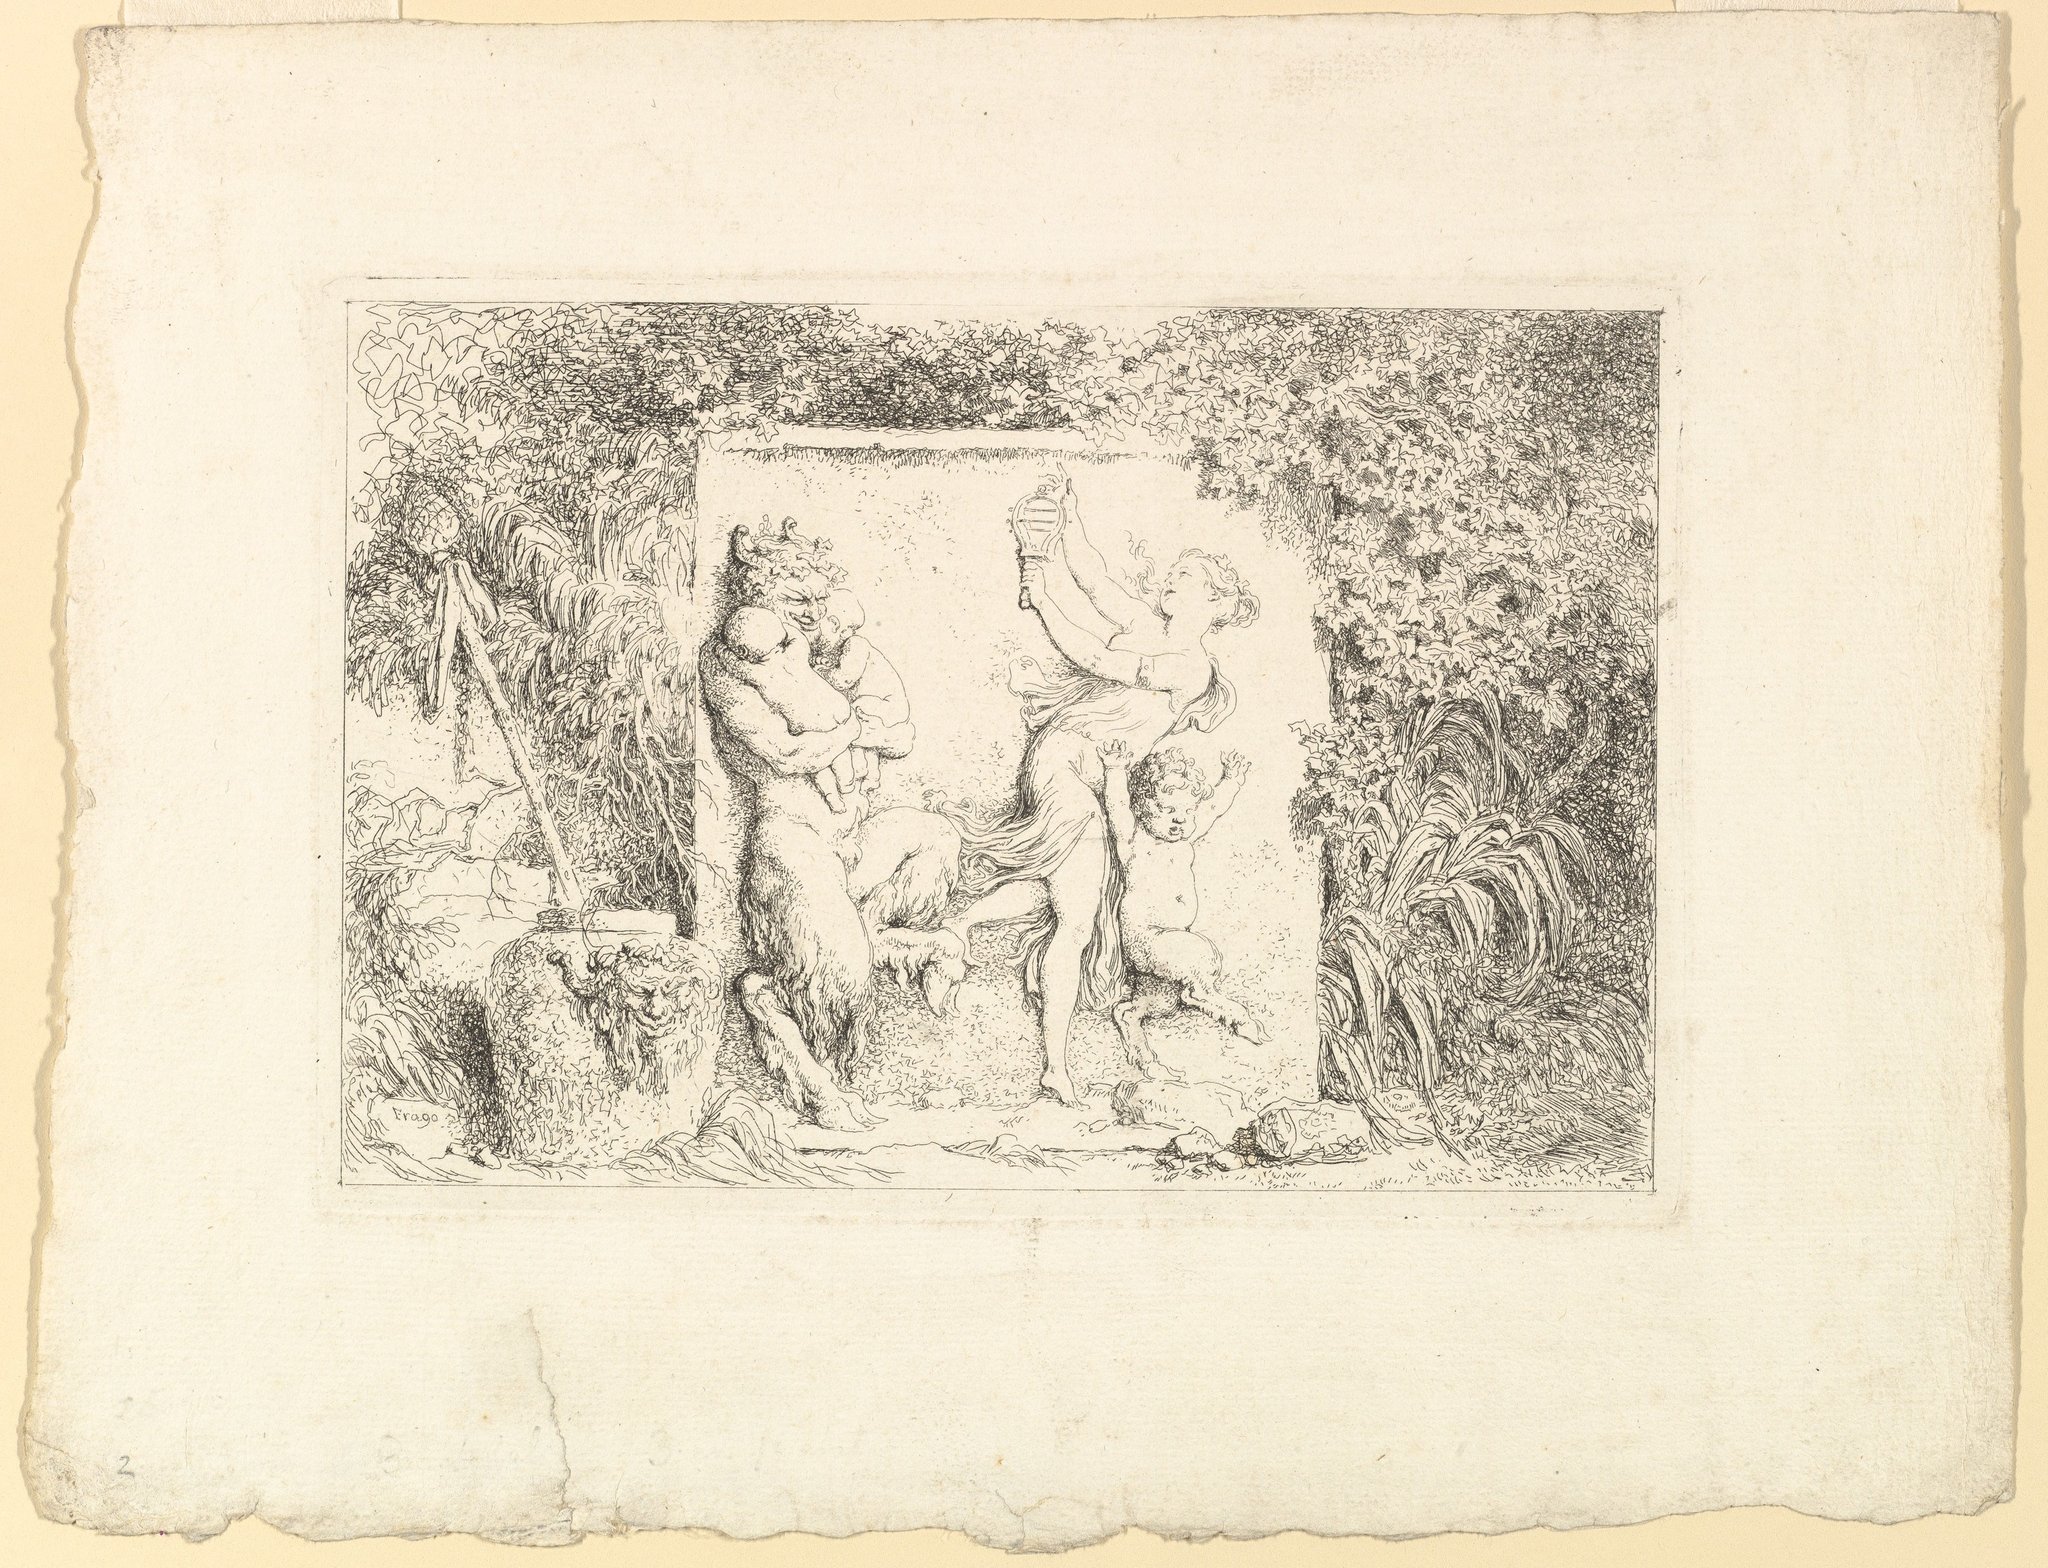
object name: print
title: The Satyrs' Dance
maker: jean honoré fragonard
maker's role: artist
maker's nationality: french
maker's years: 1732-1806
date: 1763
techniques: etching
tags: dancing,nymphs,satyrs